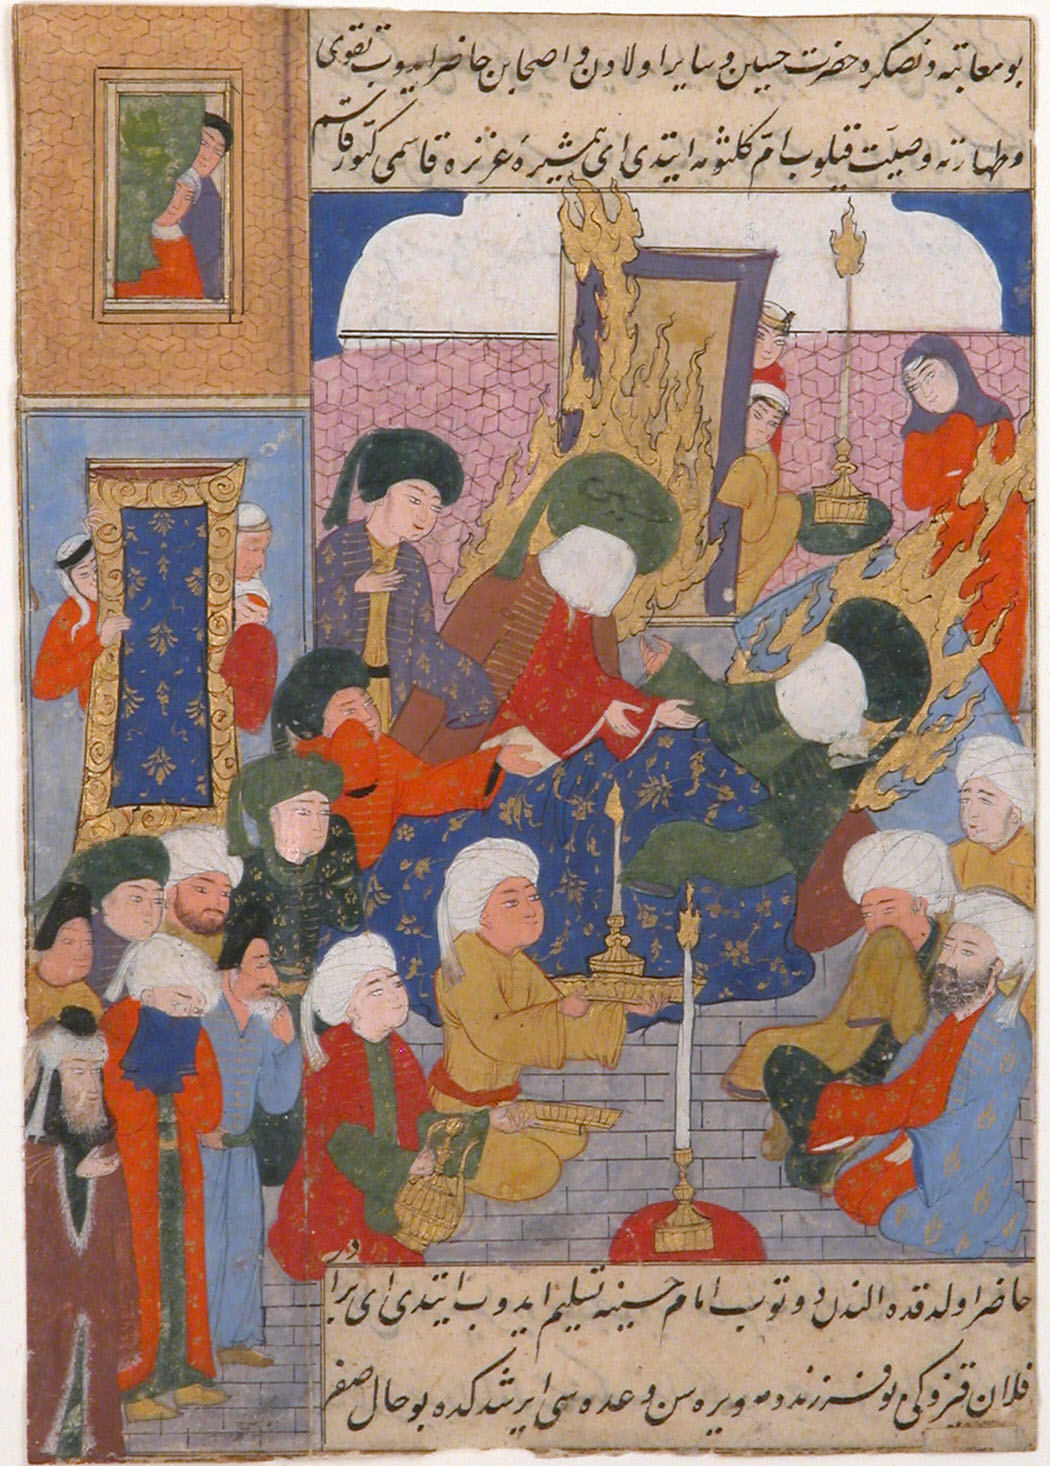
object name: folio from an illustrated manuscript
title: "Husayn at the Bedside of the Dying Hasan", Folio from a Hadiqat al-Su'ada of Fuzuli (Garden of the Blessed)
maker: fuzuli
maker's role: poet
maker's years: 1455-1581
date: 1567-1600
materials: gold, ink, paper, watercolor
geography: turkey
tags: men,women,death